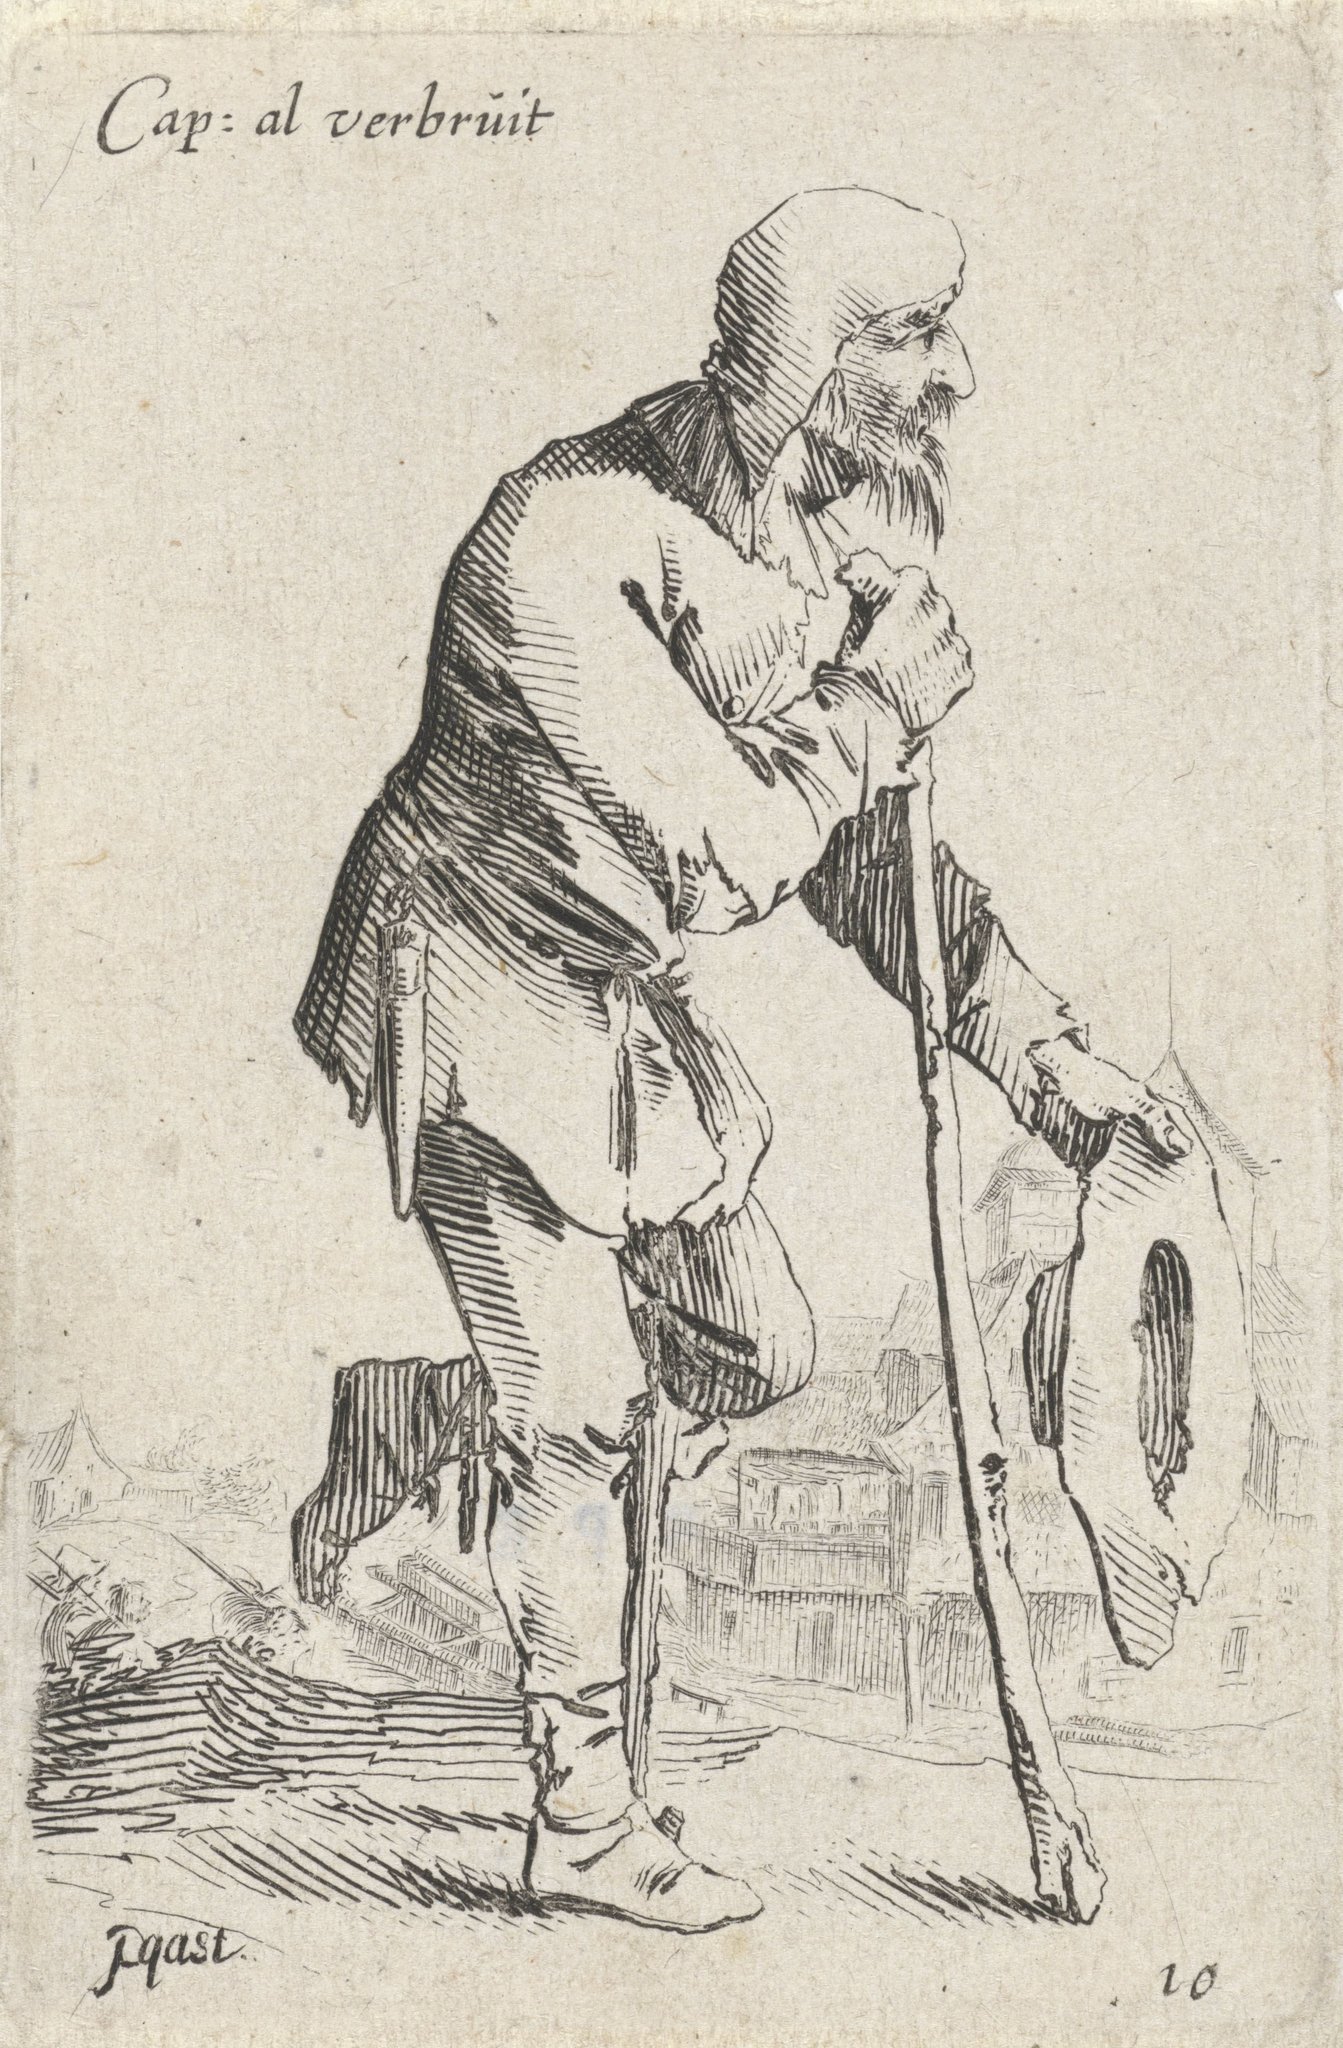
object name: print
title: T'Leven Der Boeren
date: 1630-1665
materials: paper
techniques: etching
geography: amsterdam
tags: person with a physical disability, beggar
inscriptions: collector's mark: Lugt 2233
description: De prent maakt deel uit van een twaalfdelige serie prenten met voorstellingen van boeren. Sommige figuren in deze serie zijn ook aangeduid als 'kreupele', wat in de 17de eeuw een generieke term was voor mensen met lichamelijke beperkingen.